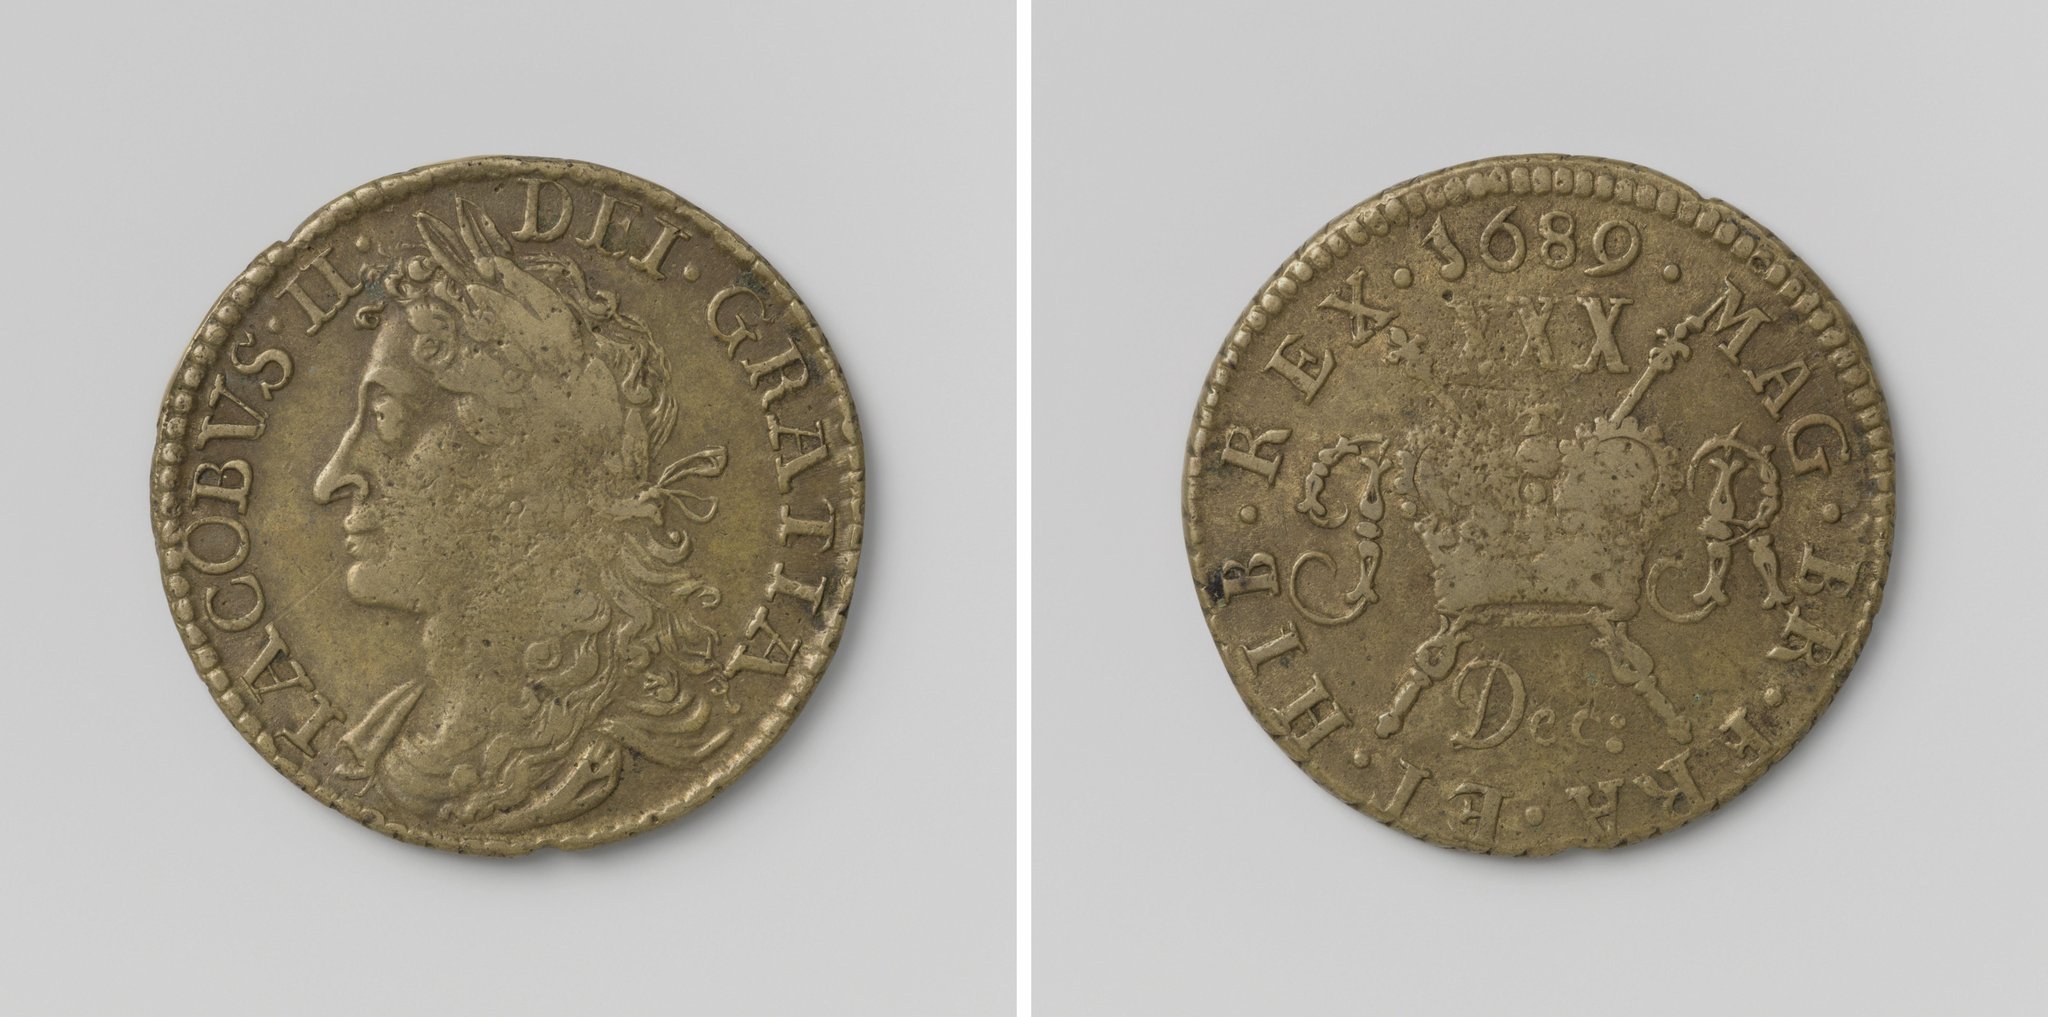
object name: dertig penny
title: Halve crown, noodmunt van Jacobus II, koning van Engeland, uit december 1689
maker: Anonymous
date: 1612-1689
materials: copper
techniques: striking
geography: ireland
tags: jacobus ii (koning van engeland en schotland)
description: Voorzijde: borststuk man met lauwerkrans binnen omschrift. Keerzijde: kroon, waardoor twee gekruiste scepters steken tussen monogram van letters J en R; boven kroon Romeinse cijfer XXX, onder kroon opschrift "Dec: " binnen omschrift